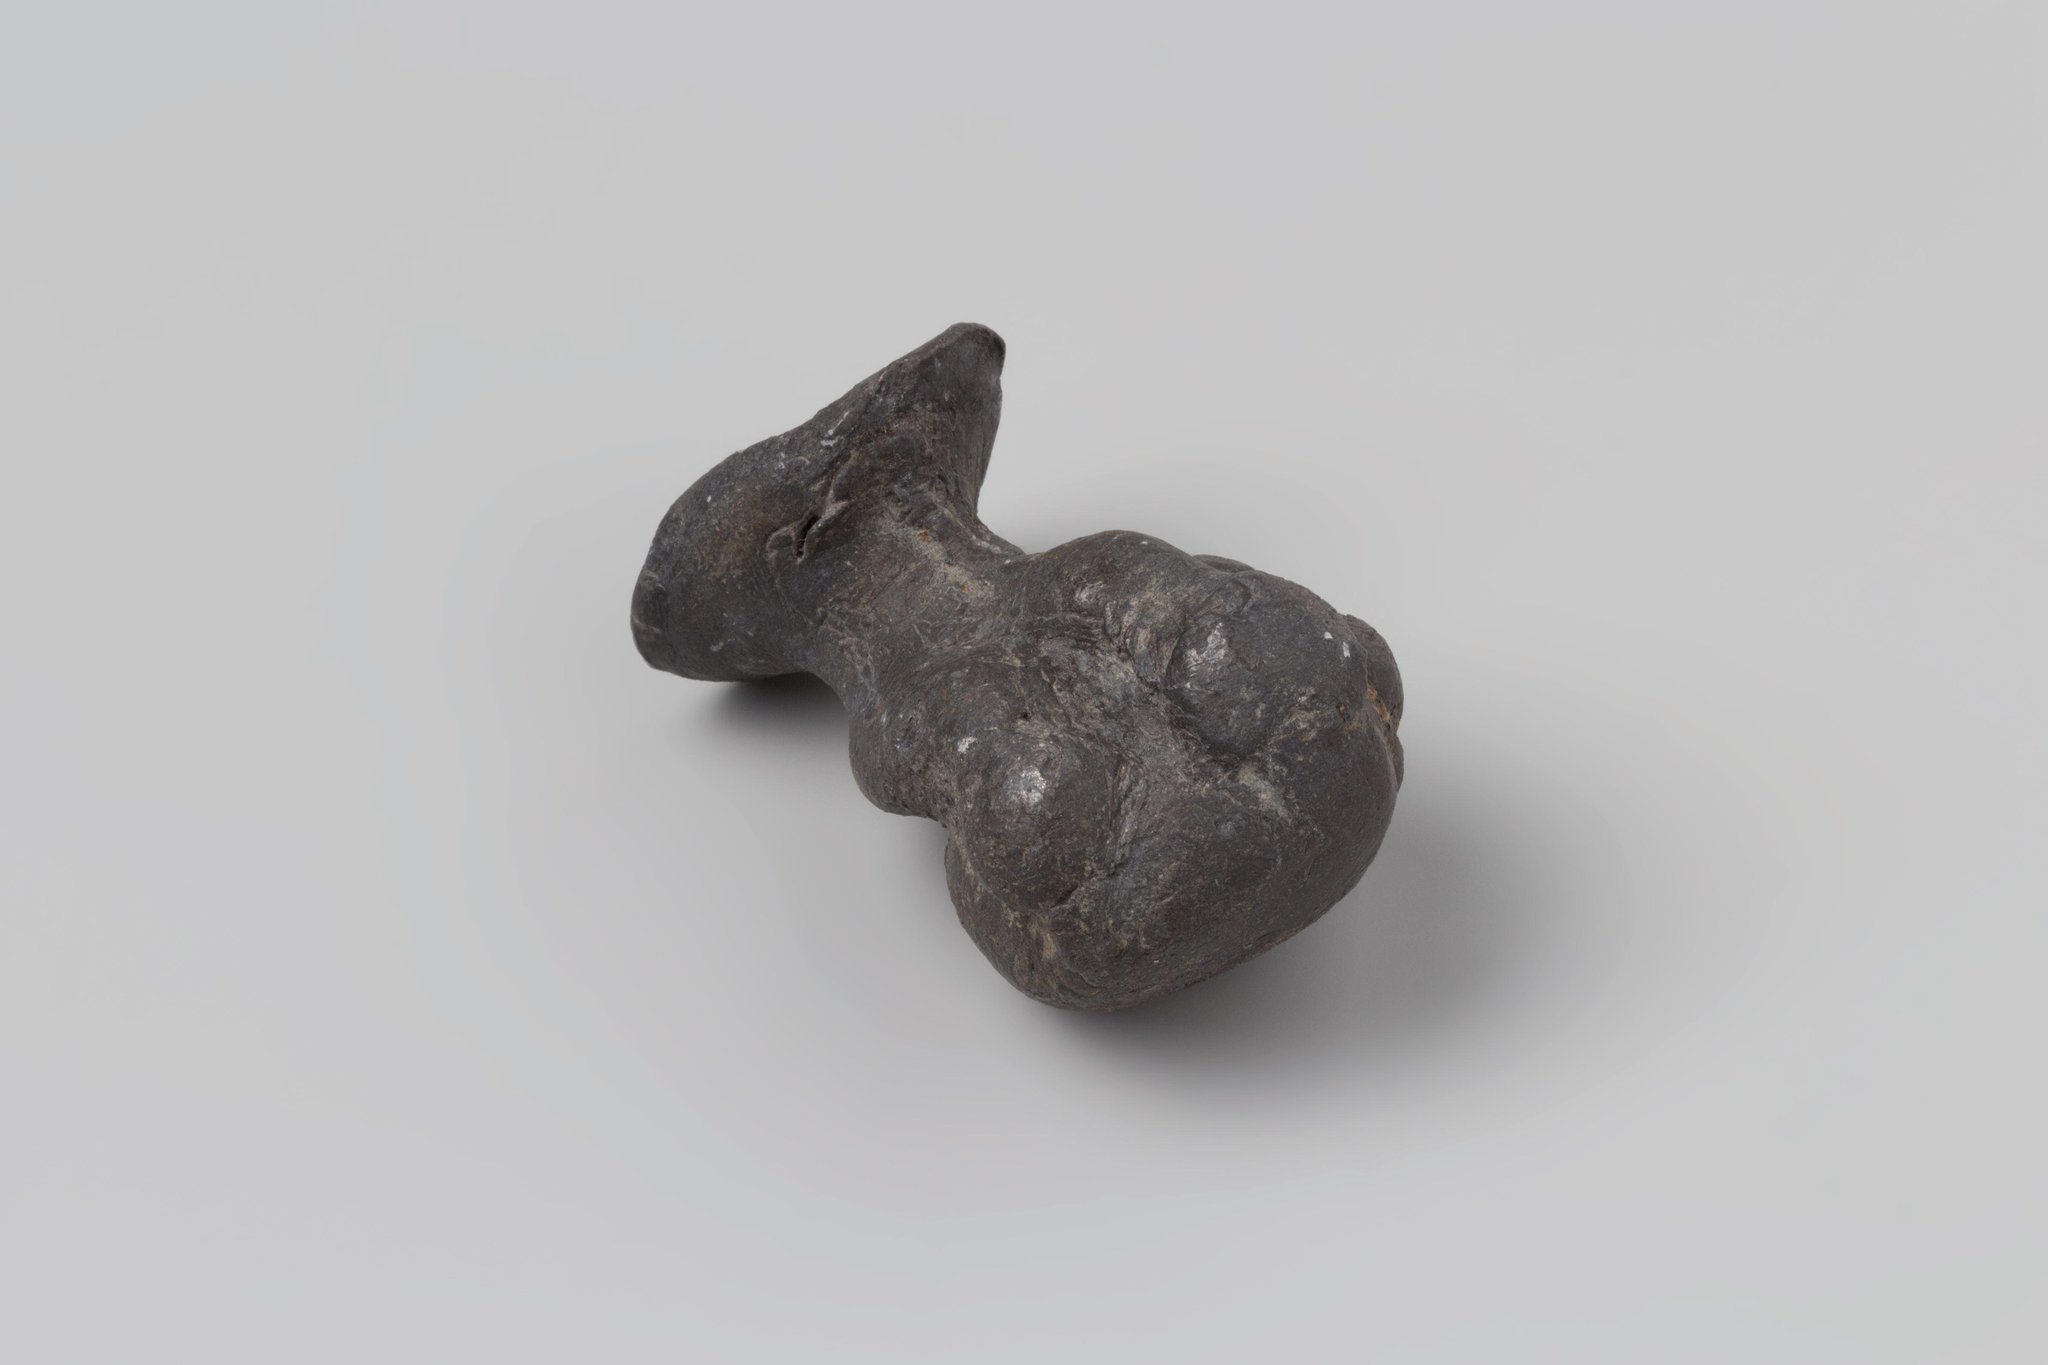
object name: vessel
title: Poot van vaatwerk uit het wrak van de Oost-Indiëvaarder 't Vliegend Hart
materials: tin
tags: 't vliegend hart (schip), verenigde oostindische compagnie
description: Massief zwart dikkig pootje met stulpingen en aan een kant duidelijk het afgeplatte punt waar het ooit raakte aan de moederpot.